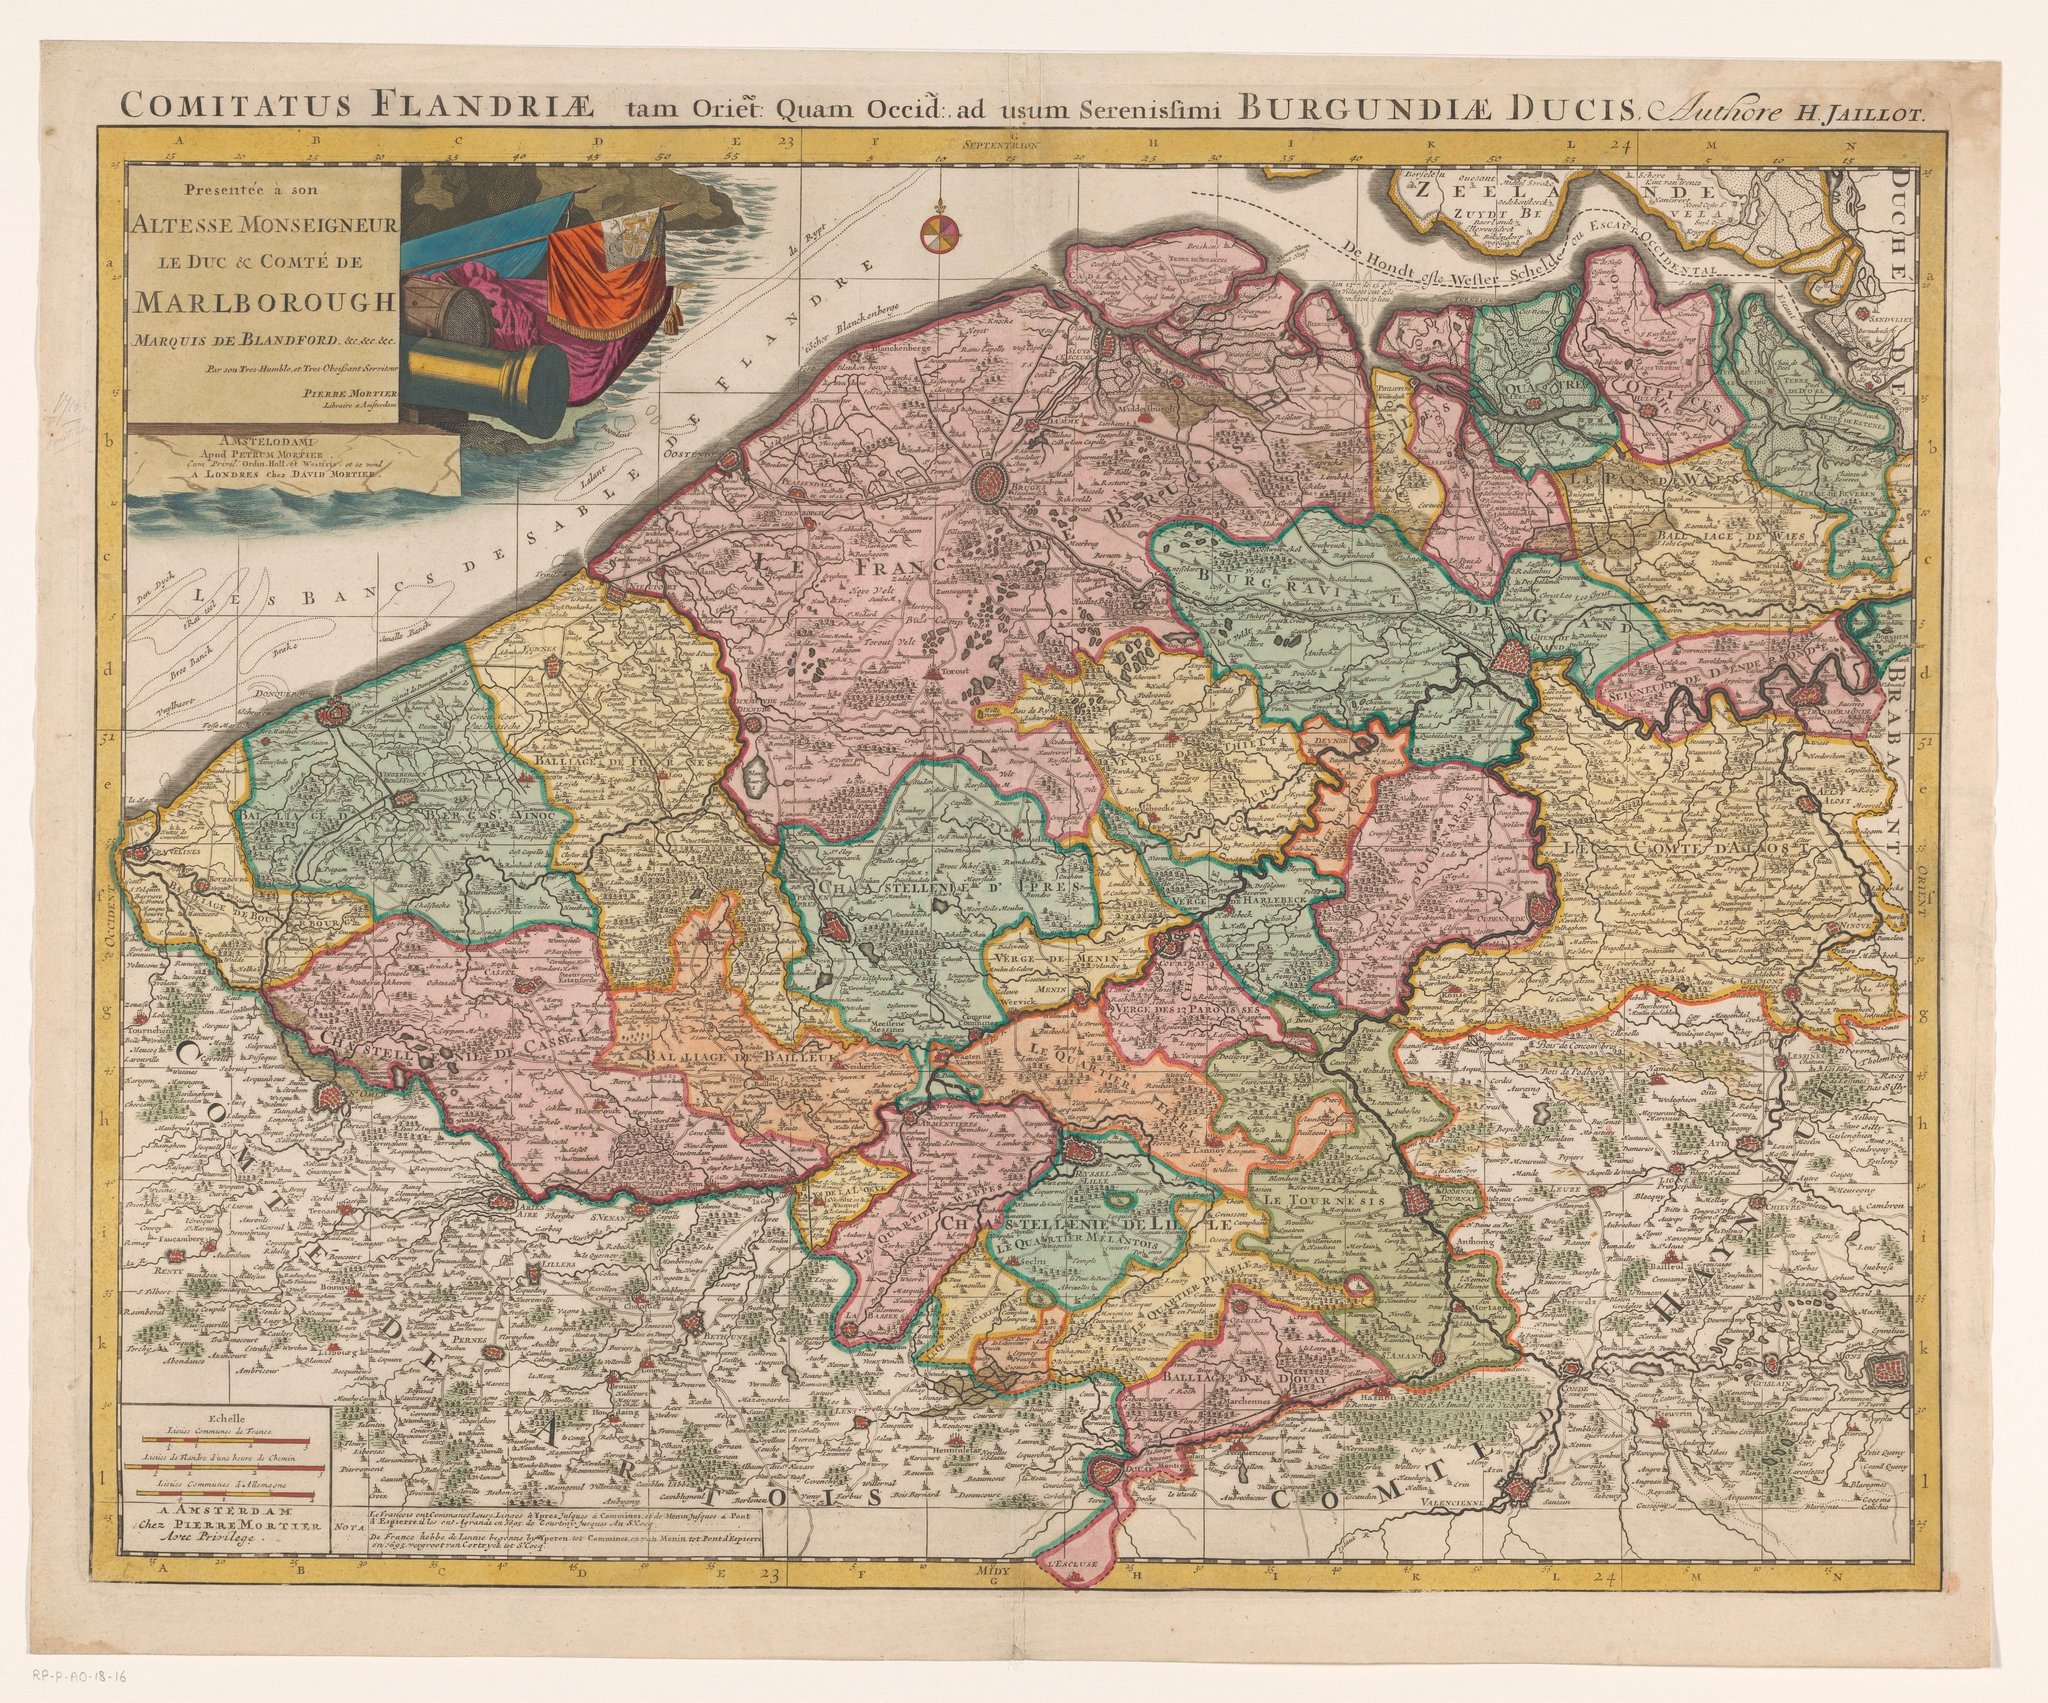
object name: print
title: Kaart van het graafschap Vlaanderen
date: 1702-1719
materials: paper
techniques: engraving, etching, hand coloring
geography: amsterdam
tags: maps of separate countries or regions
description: Kaart van het graafschap Vlaanderen. In een balk boven de kaart de titel. Linksboven een cartouche met opdracht. Linksonder een kader met drie schaalstokken: 3 Lieues Communes de France / 3 Lieues de Flandre d'une heure de Chemin / 2 Lieues Communes d'Allemagne. De kaart is voorzien van een zoekrooster en een gradenverdeling langs de randen.